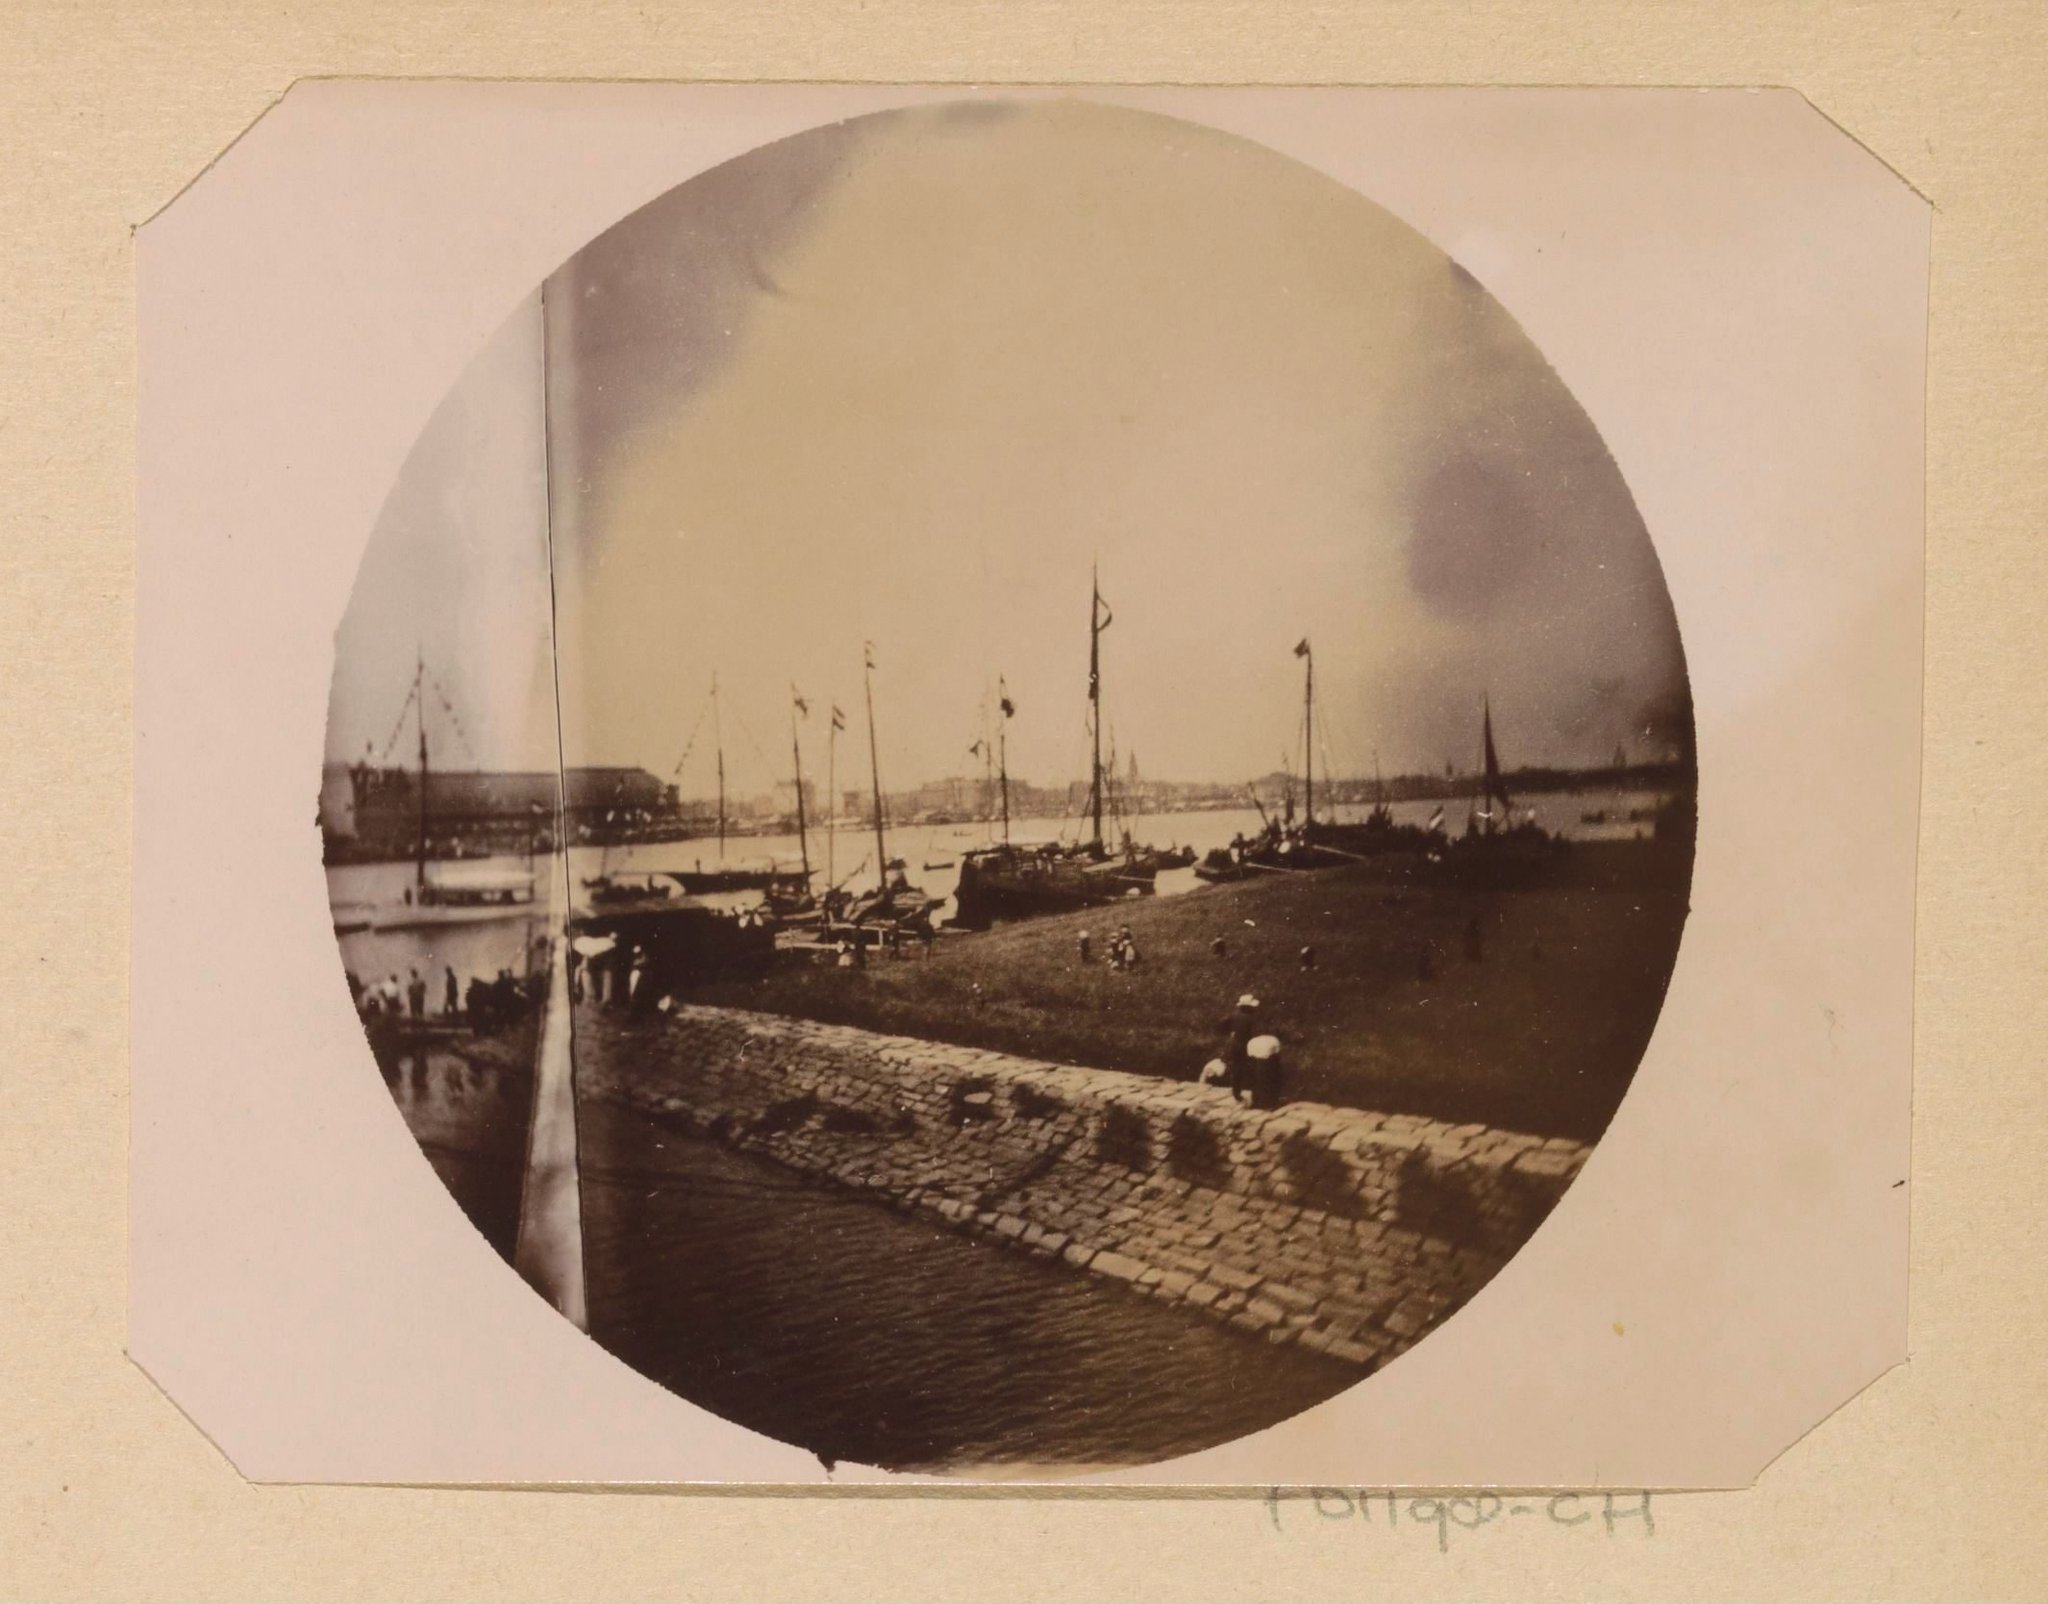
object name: photograph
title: Gezicht op het IJ tijdens de Keizersfeesten in Amsterdam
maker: johanna margaretha piek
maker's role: fotograaf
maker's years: 1870-1947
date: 1891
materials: paper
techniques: gelatin silver print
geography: amsterdam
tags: harbour, imperial celebrations 1891